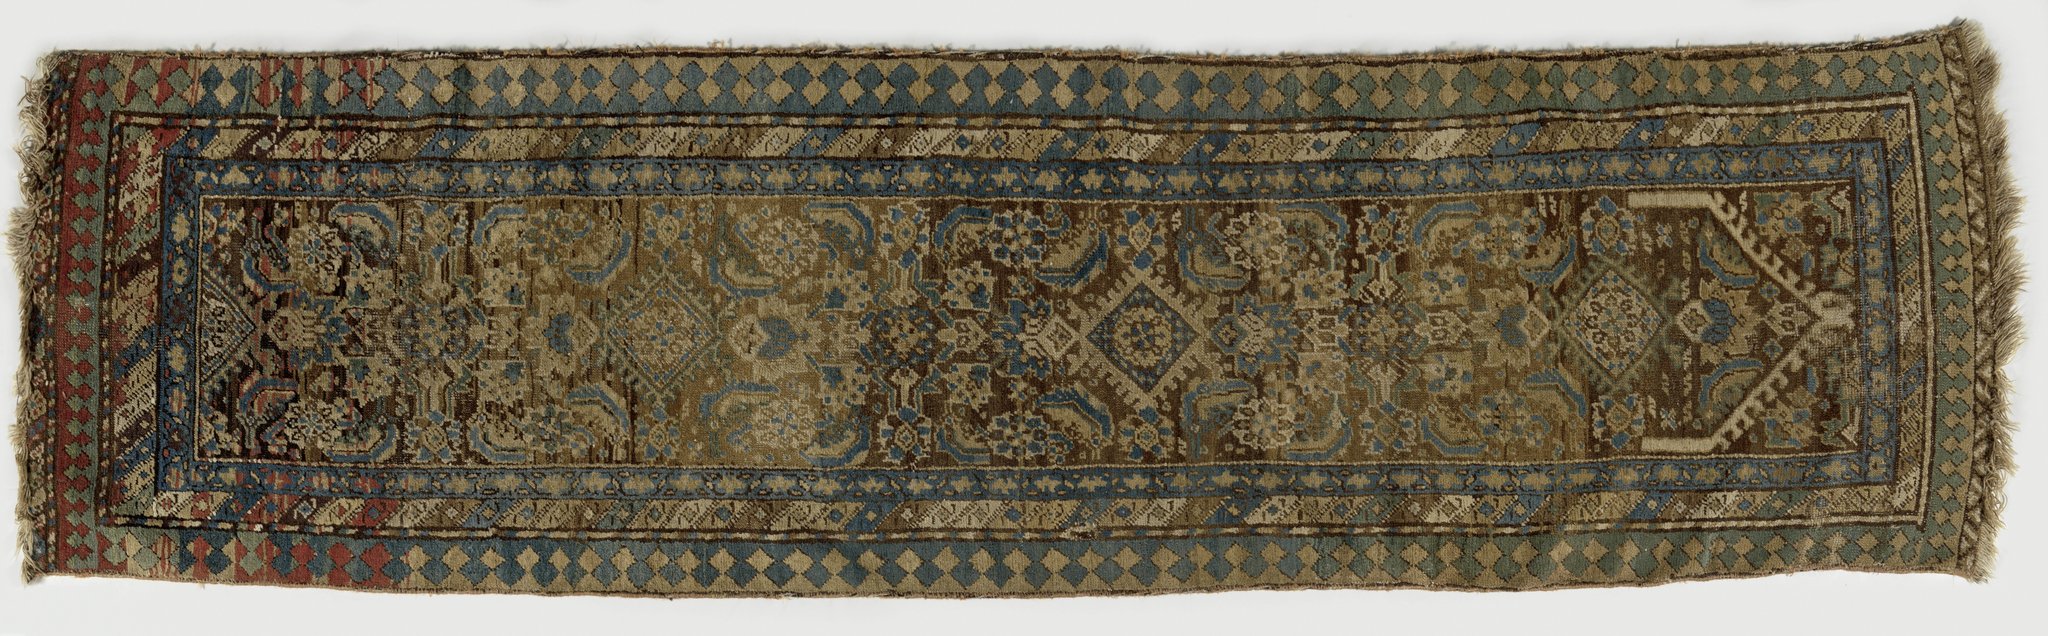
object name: oriental rug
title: Oosters tapijt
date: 1850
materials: wool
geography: hamadan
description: Oosters tapijt, loperformaat, met ruitvormig geplaatste ranken, gevuld met rozetbloemen afgewisseld door kleine ruitvormige medaillons met palmetten. Drie randen waarvan de binnenste versierd is met een bloemrank en de buitenste met een kantelenrand.